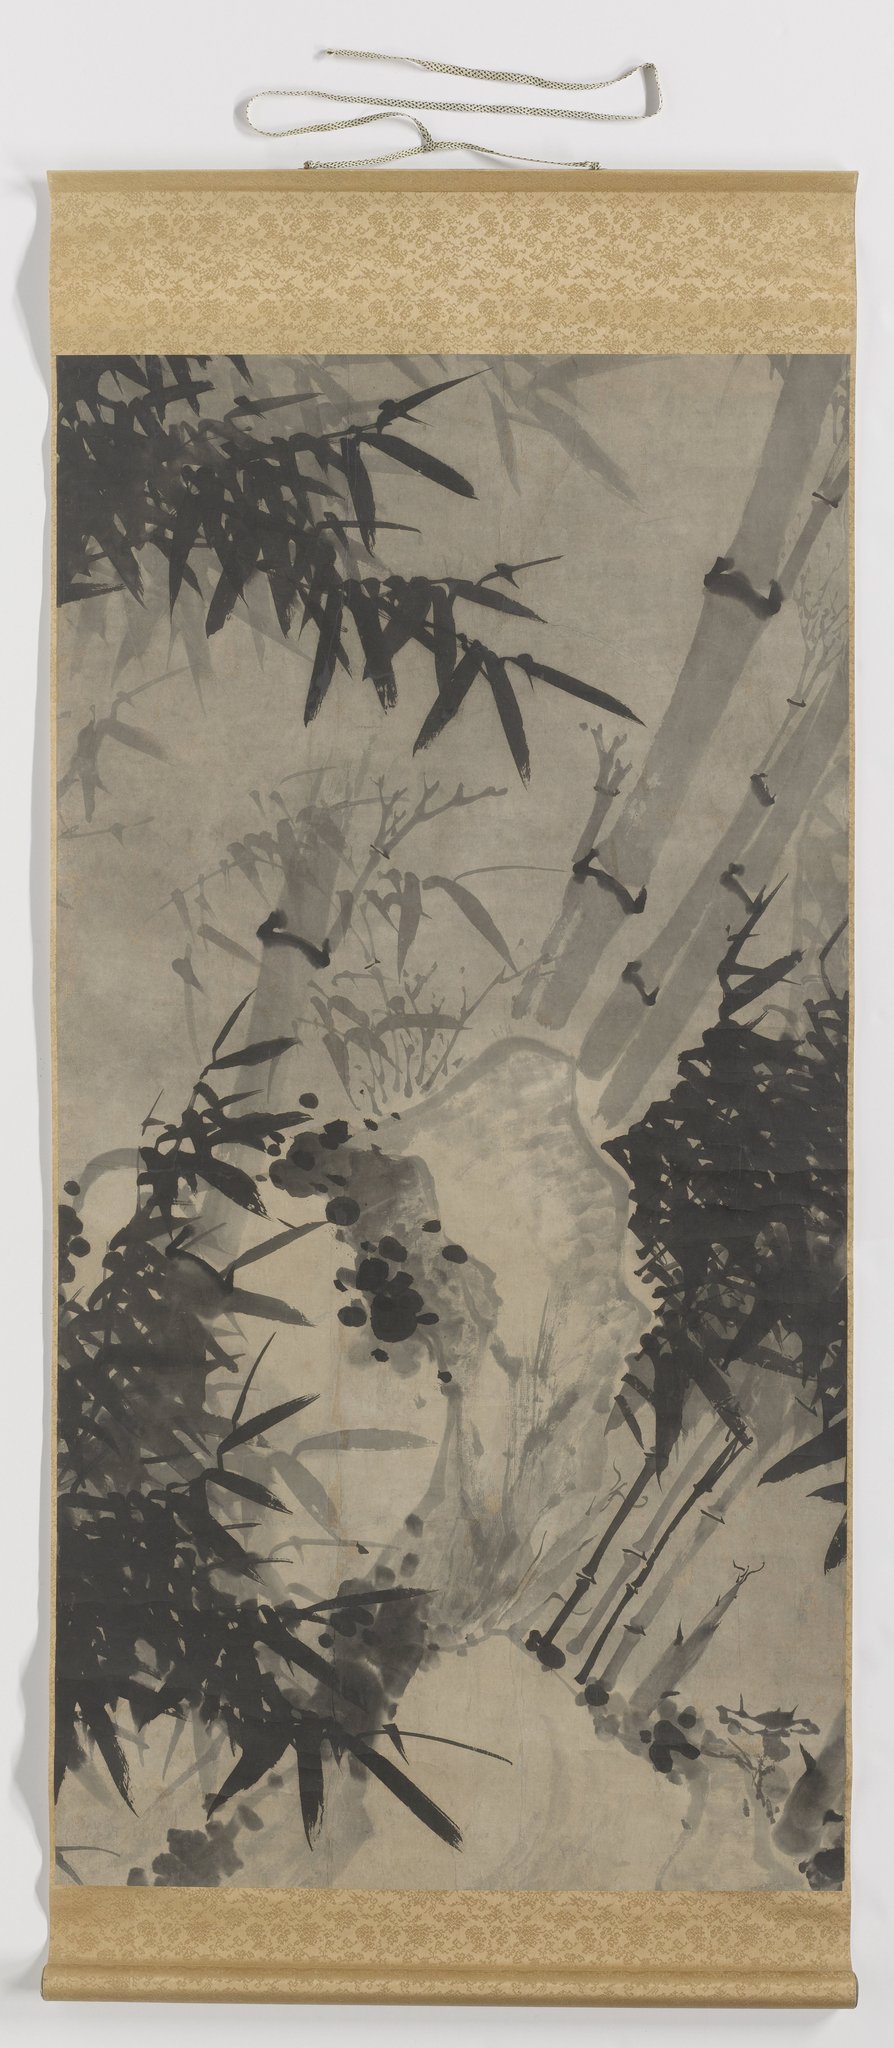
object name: hanging scroll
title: Bamboo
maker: zhengxing (bijnaam wuzhai)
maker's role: painter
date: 1675-1750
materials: ink, paper, silk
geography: china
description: These four hanging scrolls are examples of Chinese bamboo painting. Central to this genre is mastery of the brush. The bamboo stem segments as well as the individual leaves are all rendered with just a single brushstroke. The artist worked fairly wet and, in addition to grey tints, made ample use of an undiluted deep black ink to create an atmosphere of lush and moist vegetation.